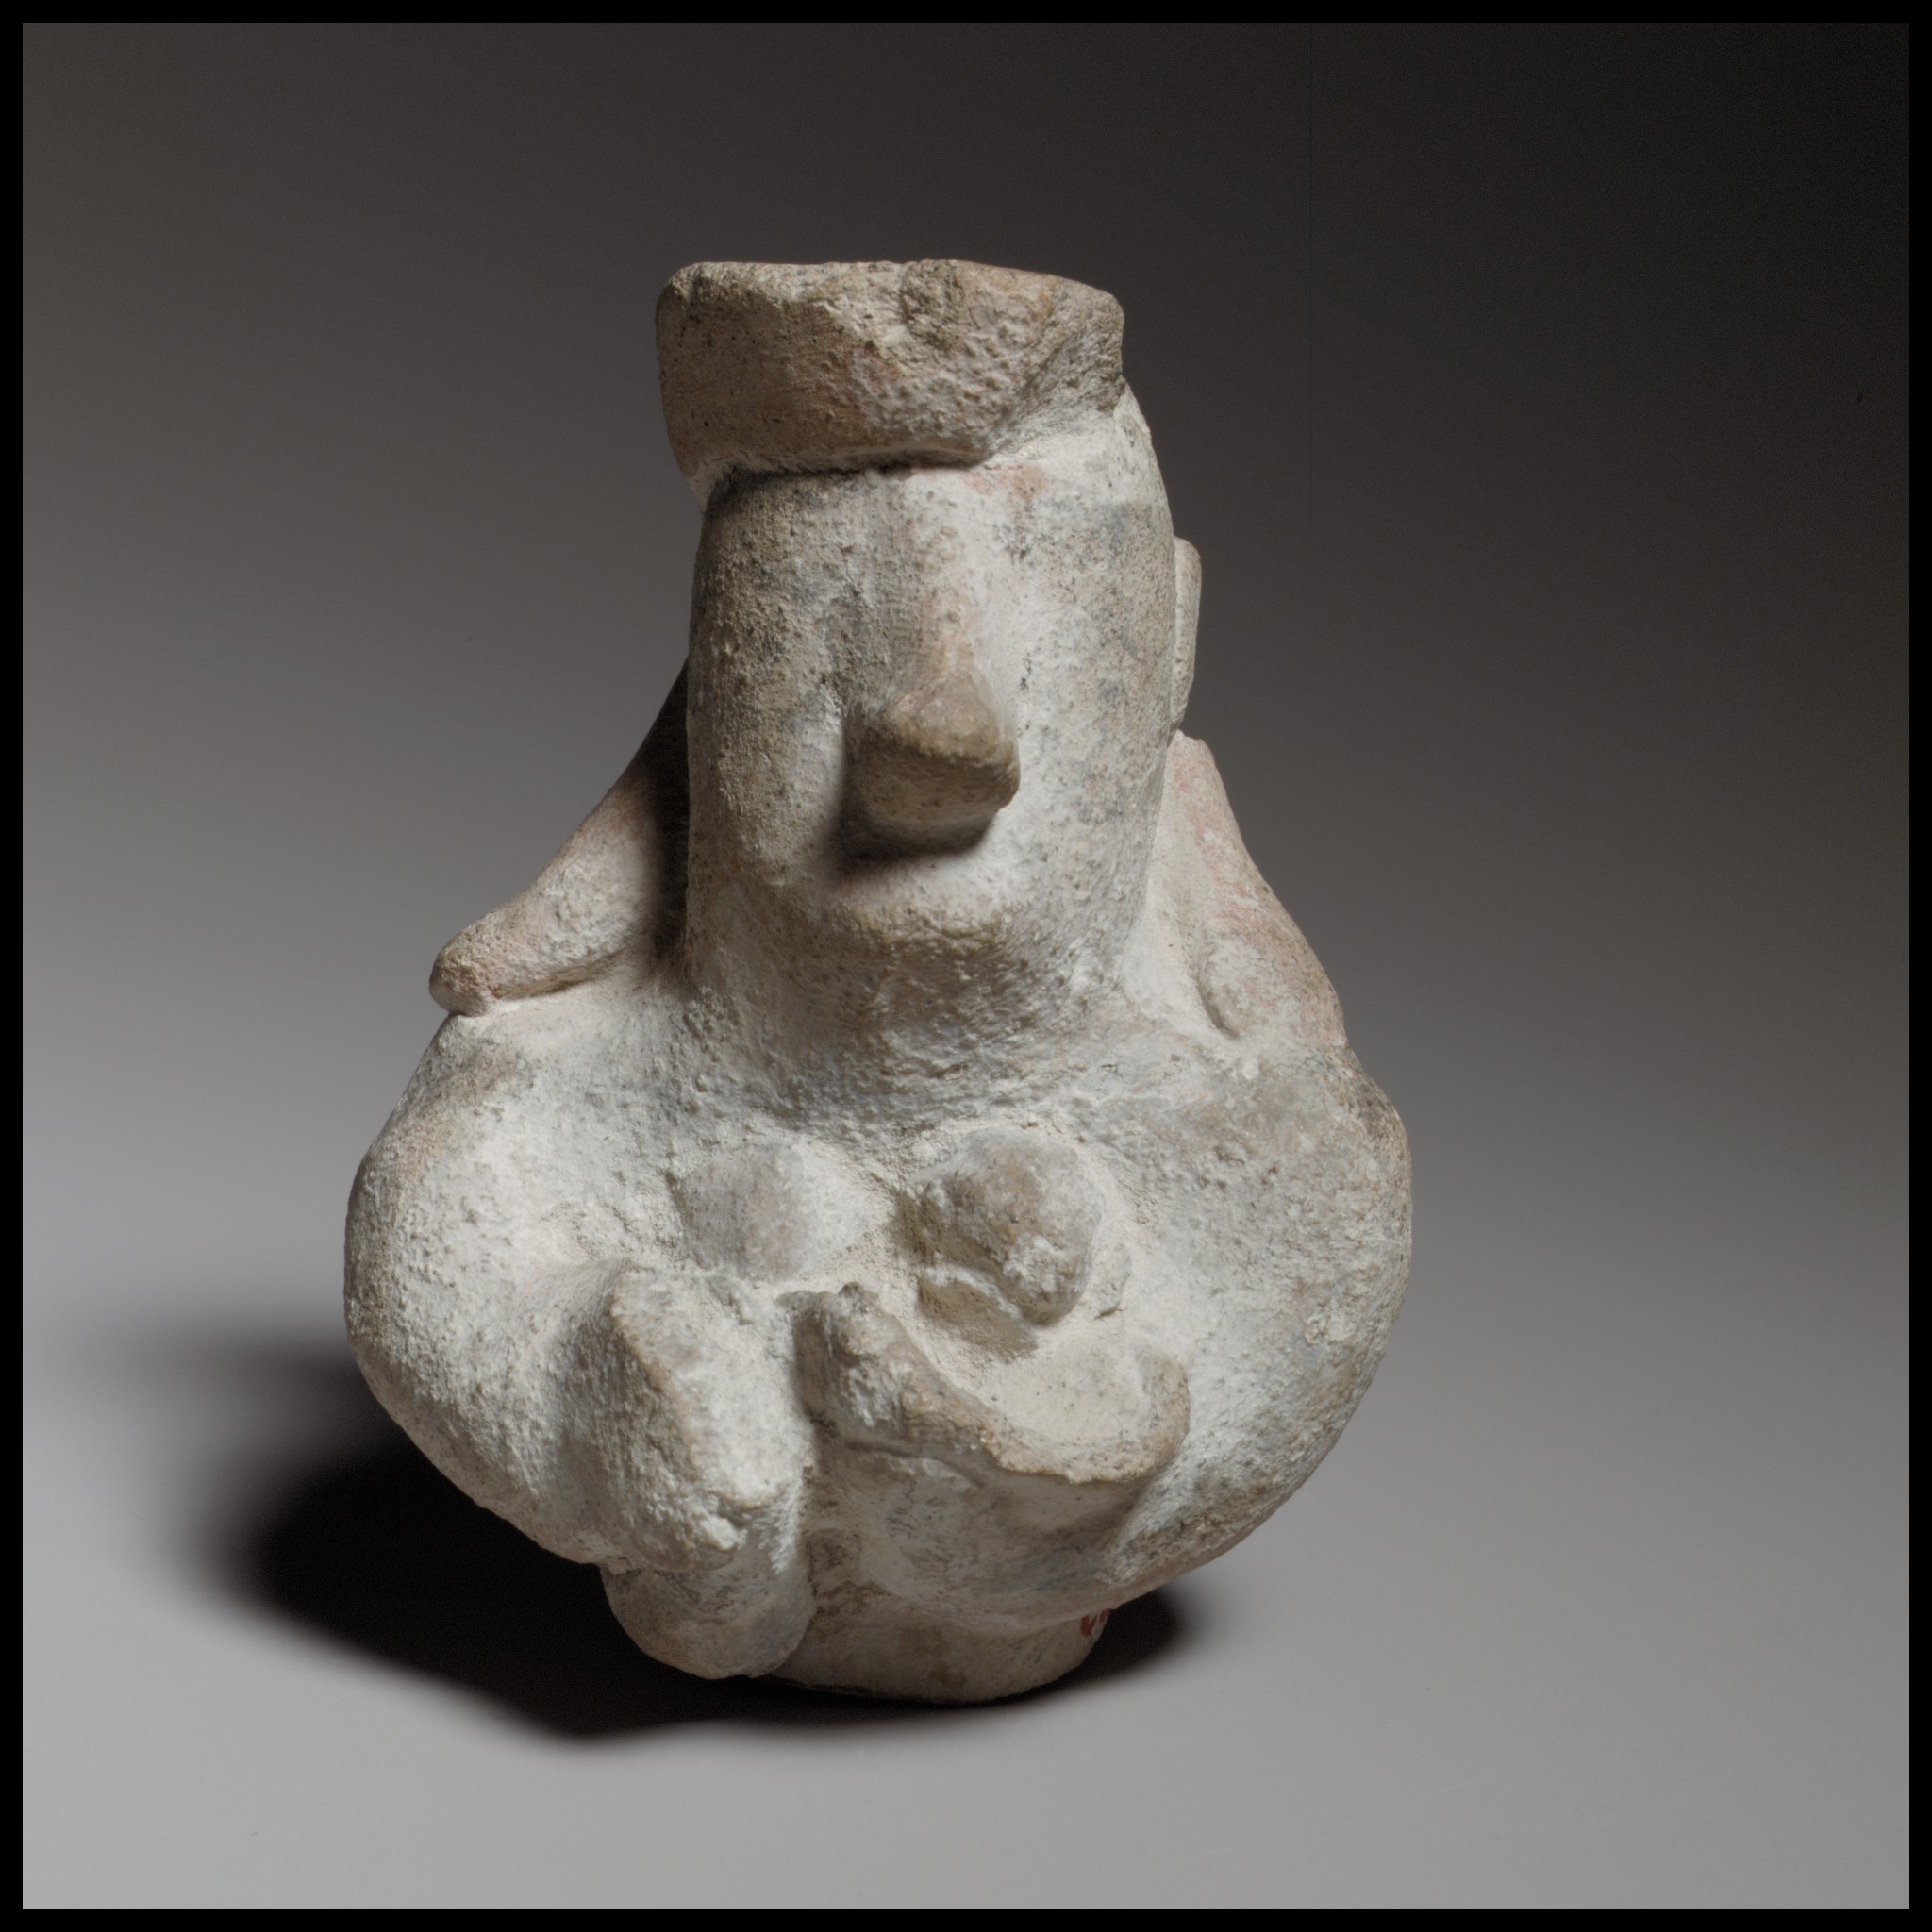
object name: statuette of a woman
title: Head and upper body of a female figurine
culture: cypriot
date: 600-480 BCE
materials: terracotta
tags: heads,women